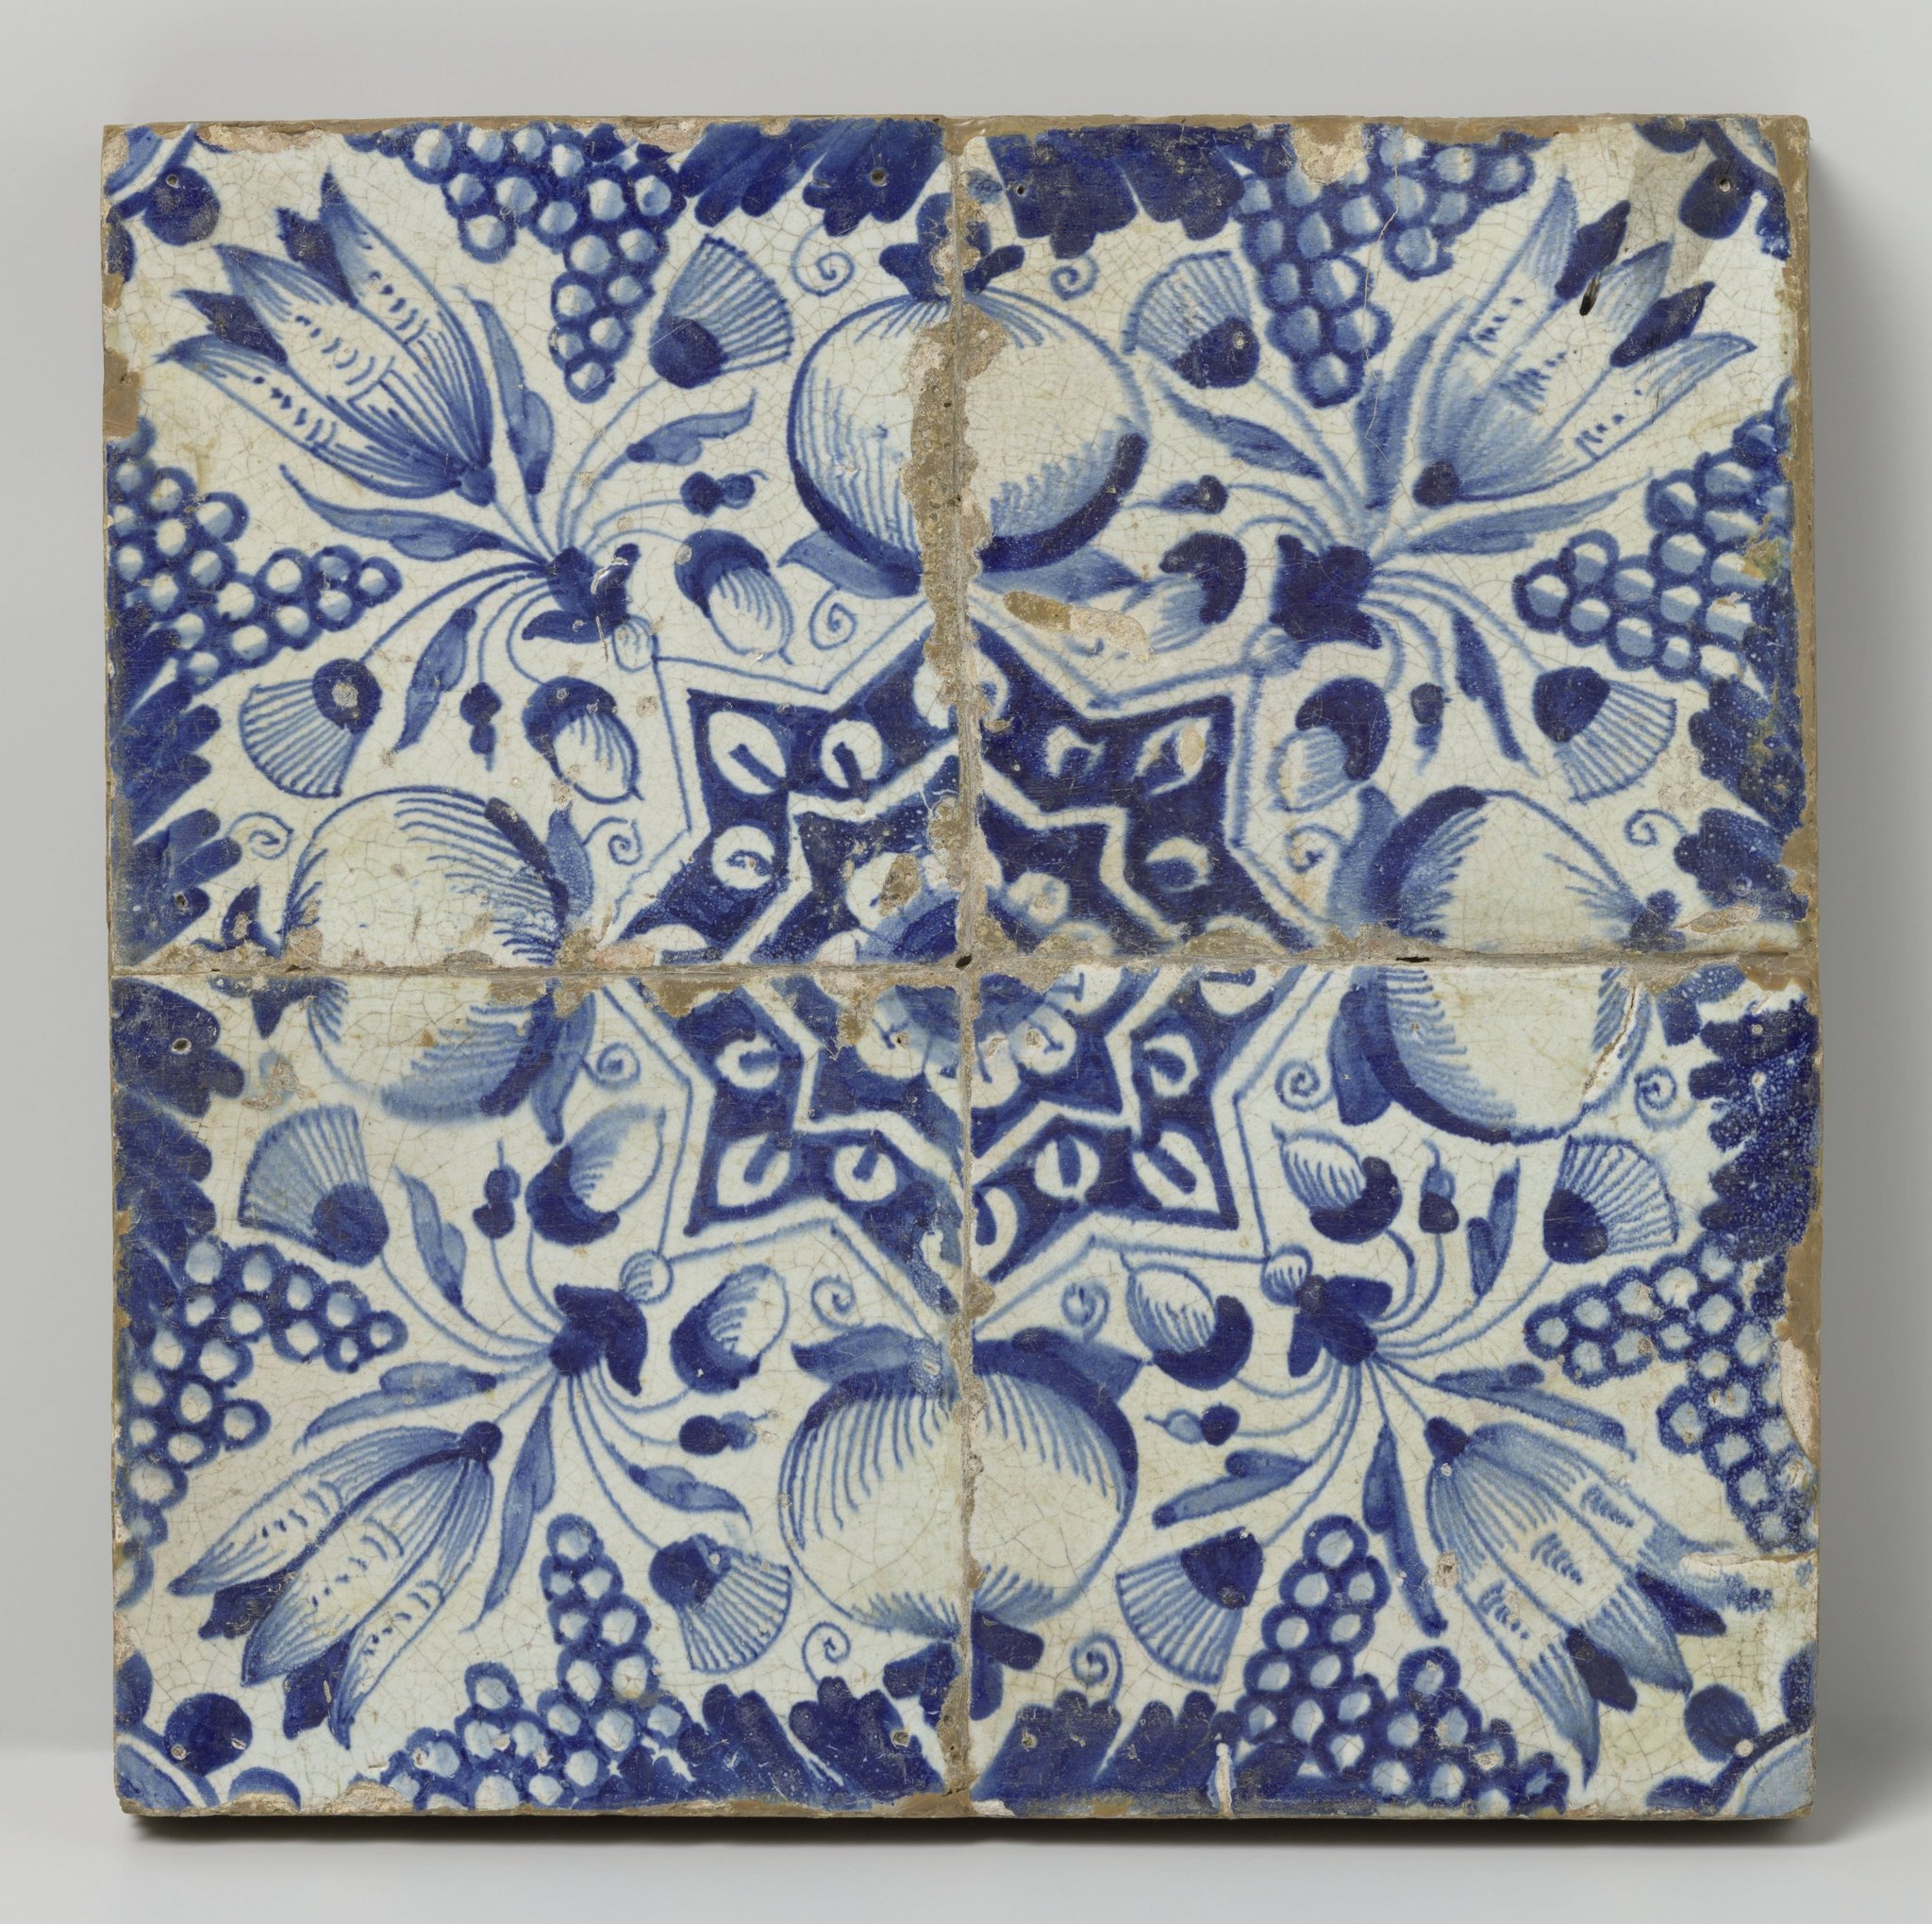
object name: tile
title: Veld van vier tegels met patroon van druiventrossen, granaatappels, tulpen en sterren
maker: Anonymous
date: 1600-1625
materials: earthenware, glaze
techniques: maiolica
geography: netherlands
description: Veld van vier tegels (2 x 2) met een blauw geschilderd patroon gevormd door vier tegels met granaatappels, druiventrossen en tulpen rond een ster.